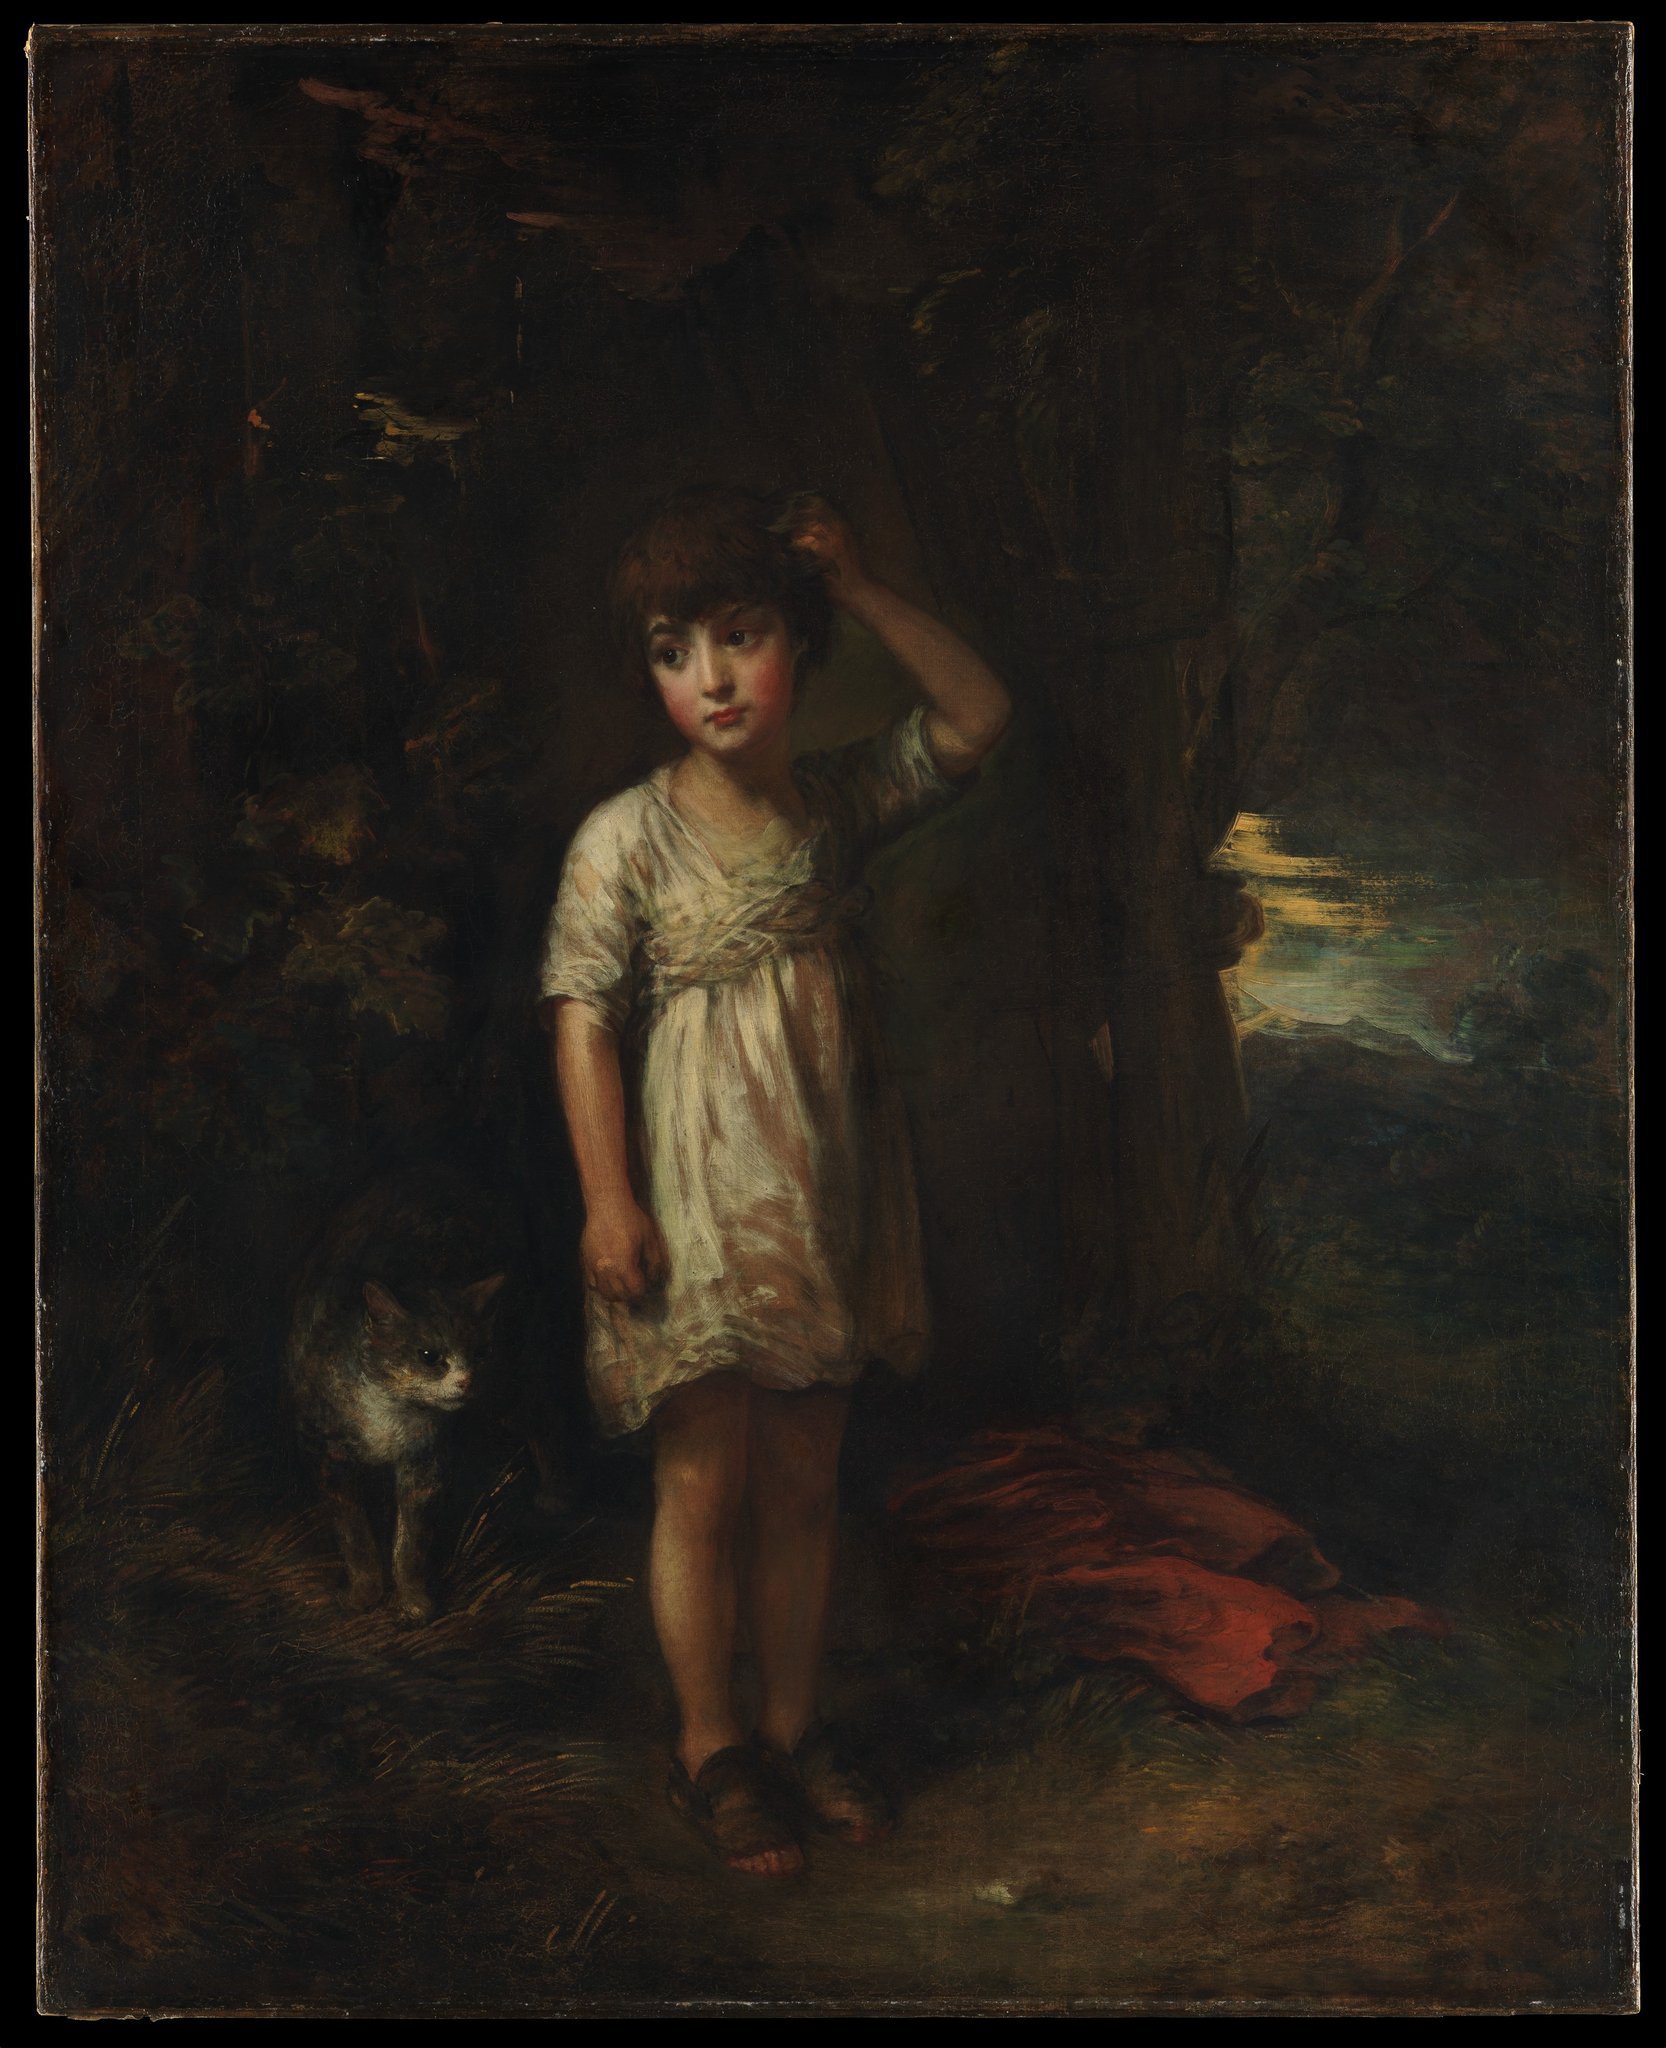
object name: painting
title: A Boy with a Cat—Morning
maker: thomas gainsborough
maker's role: artist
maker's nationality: british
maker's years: 1727-1788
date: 1787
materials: canvas, oil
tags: boys,cats